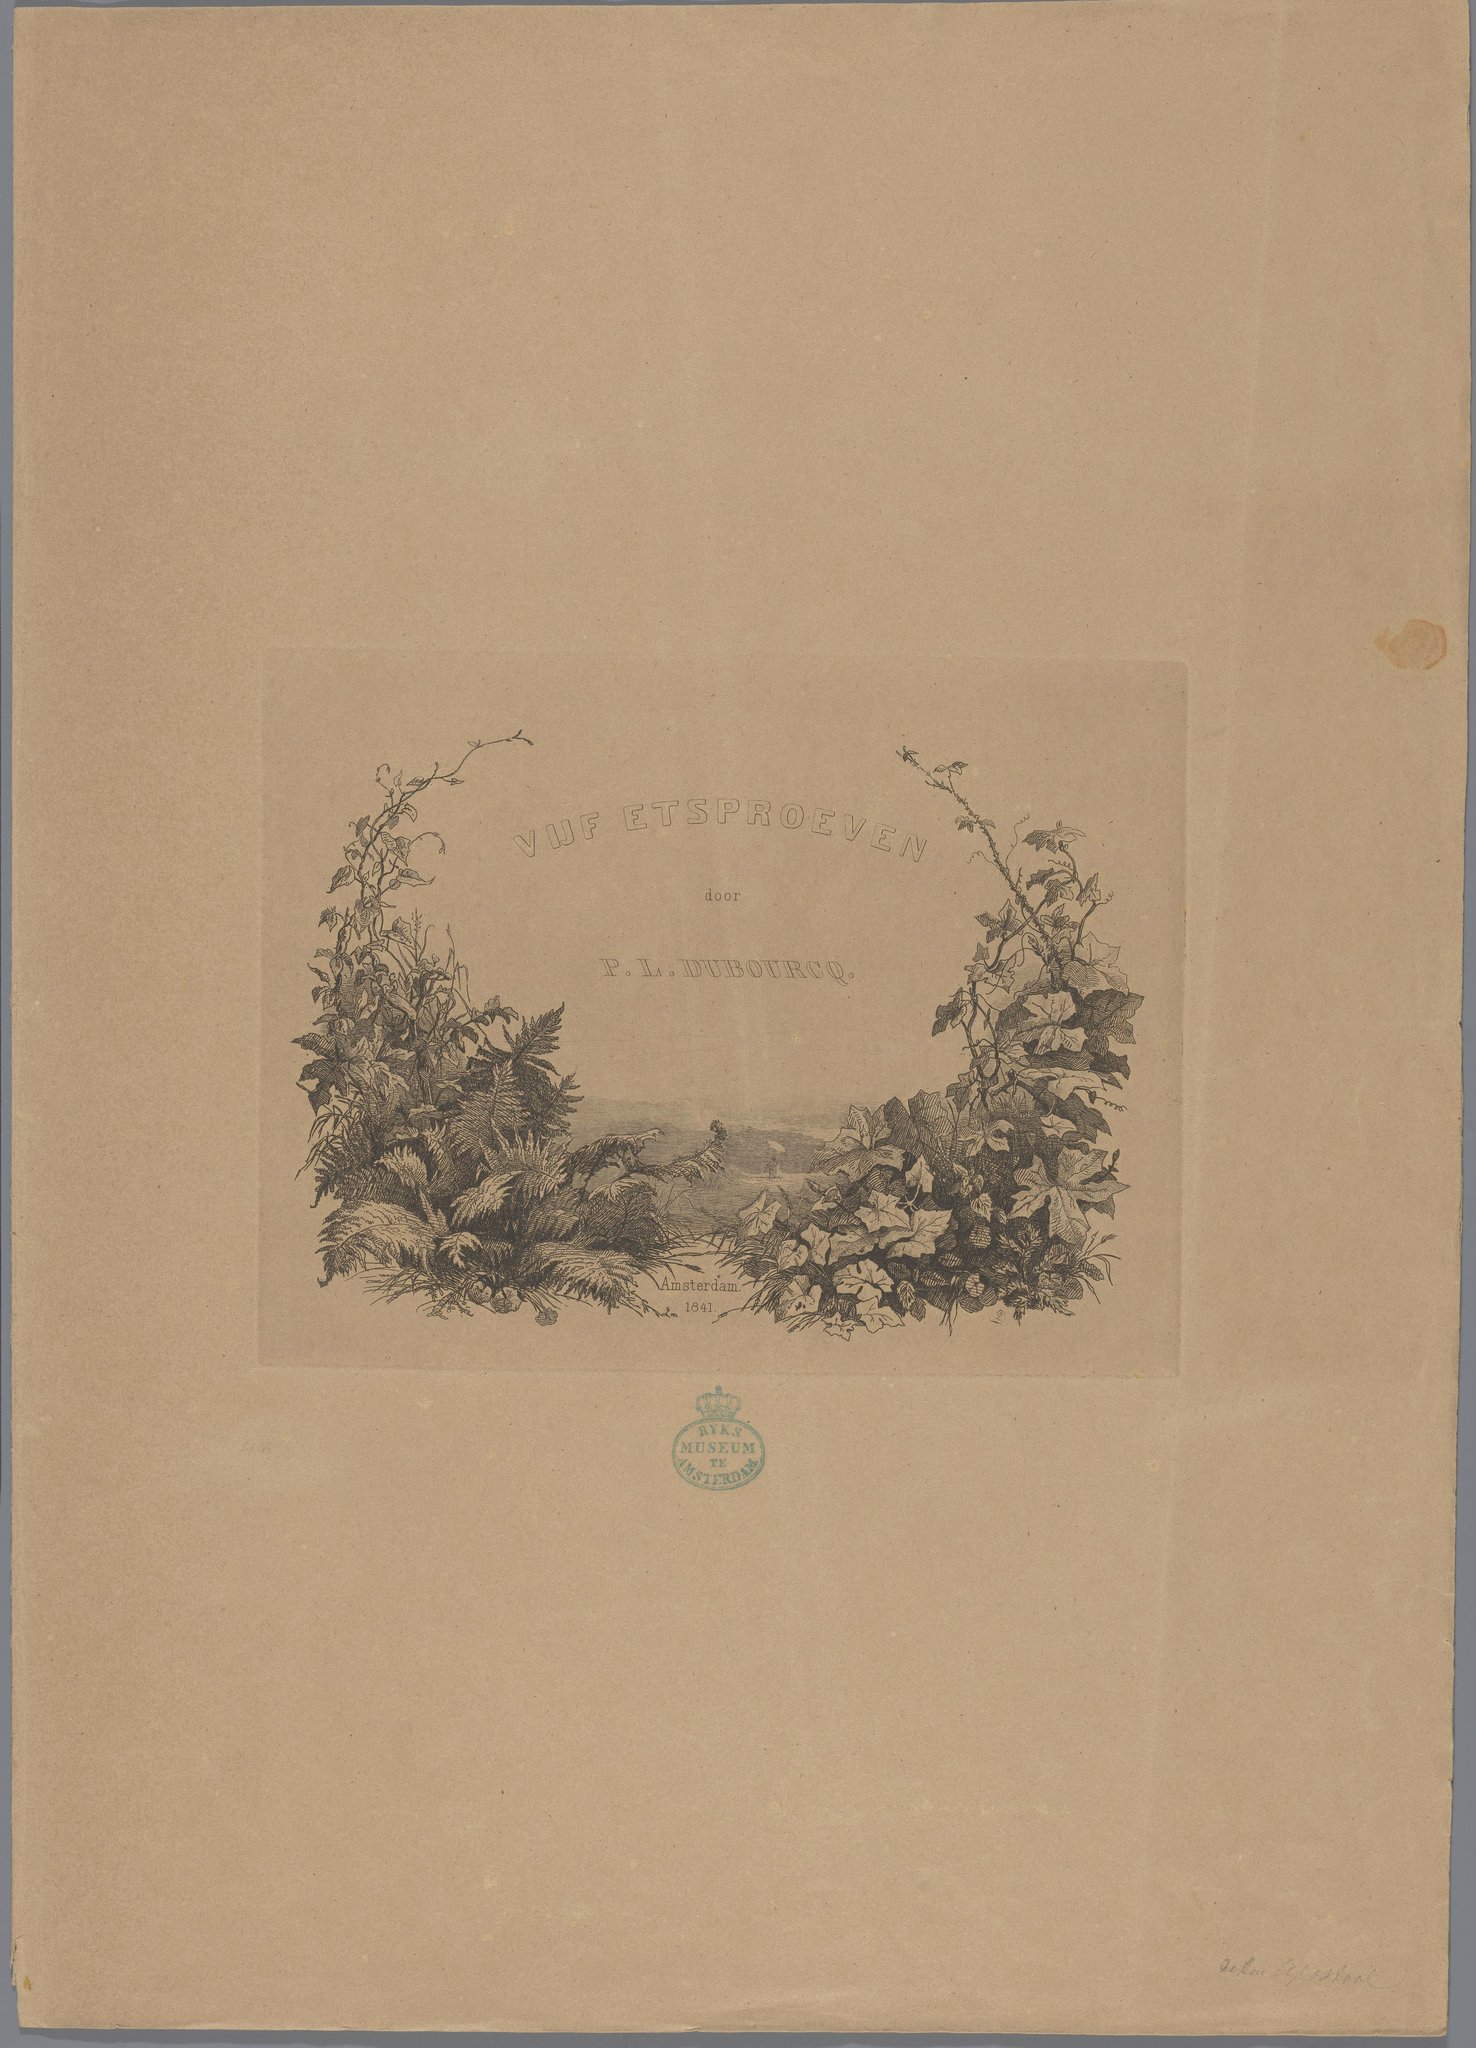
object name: print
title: Kunstenaar aan het werk in de natuur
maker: pierre louis dubourcq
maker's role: draughtsman, painter, print maker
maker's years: 1815-1873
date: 1841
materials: paper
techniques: etching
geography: netherlands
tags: working situations of artist - bb - out of doors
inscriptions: collector's mark: Lugt 12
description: Omslag voor map met vijf etsproeven. In een landschap zit een kunstenaar onder de bescherming van een parasol te werken naar de natuur. Met een florale rand van varen en klimop.